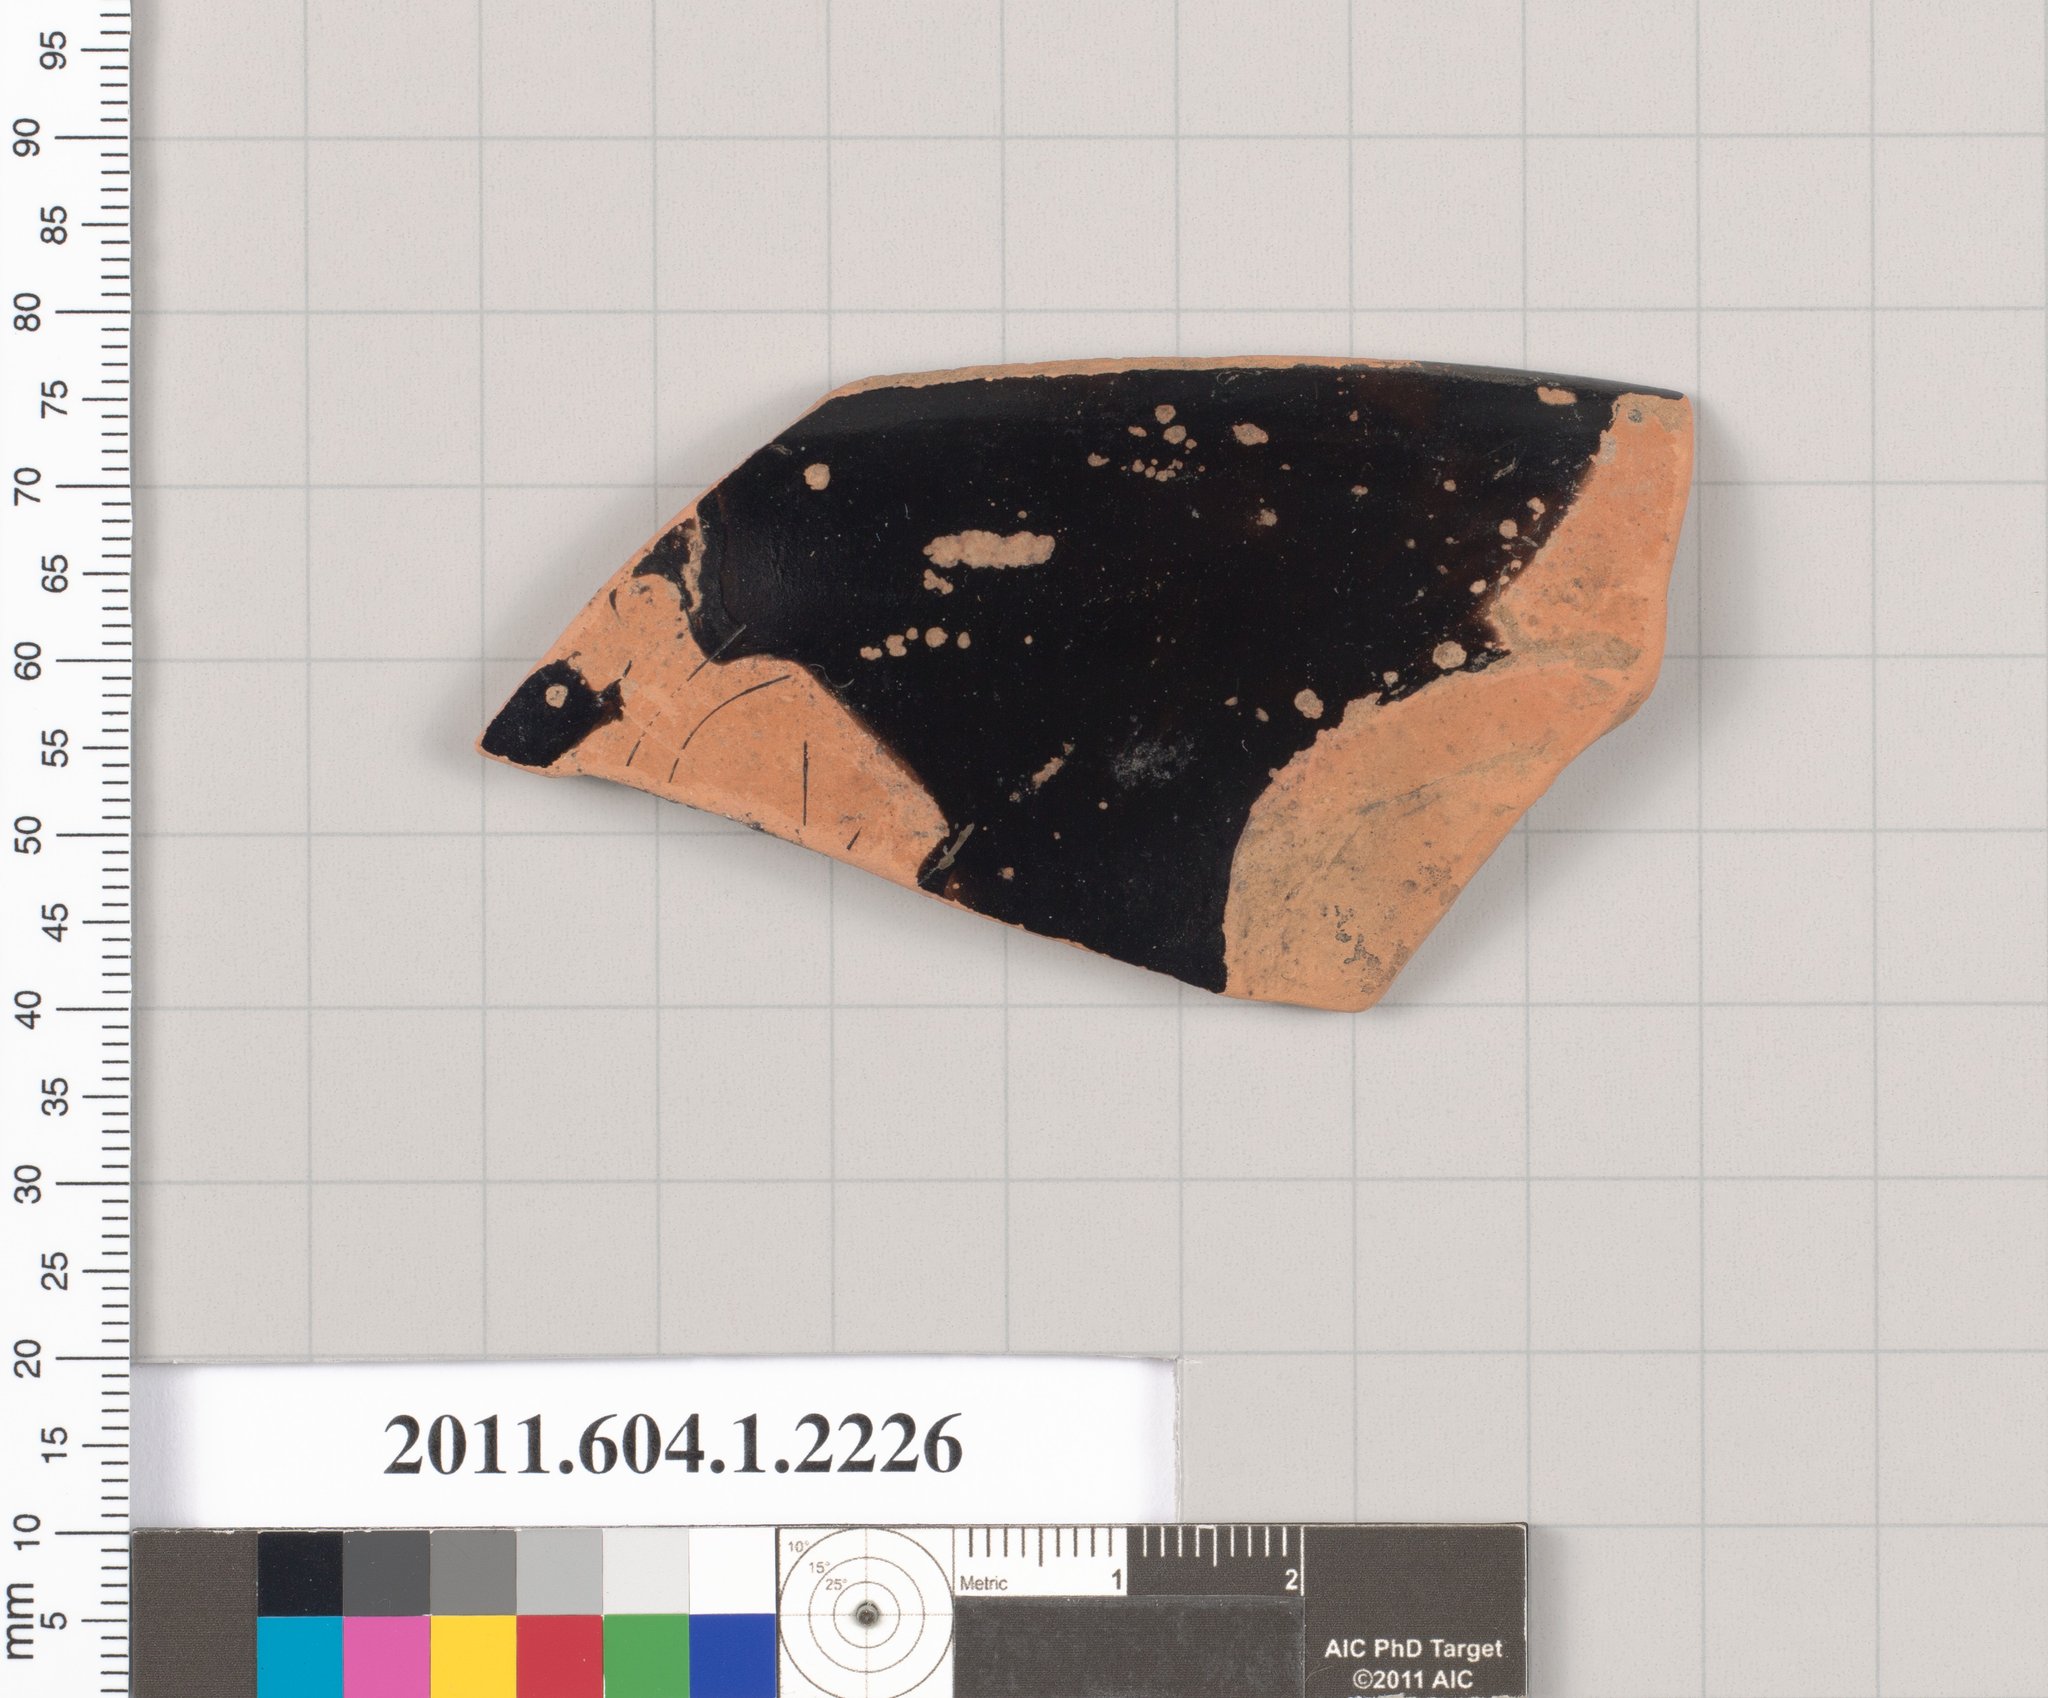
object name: kylix fragment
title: Terracotta rim fragment of a kylix (drinking cup)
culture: greek, attic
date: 467-435 BCE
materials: terracotta